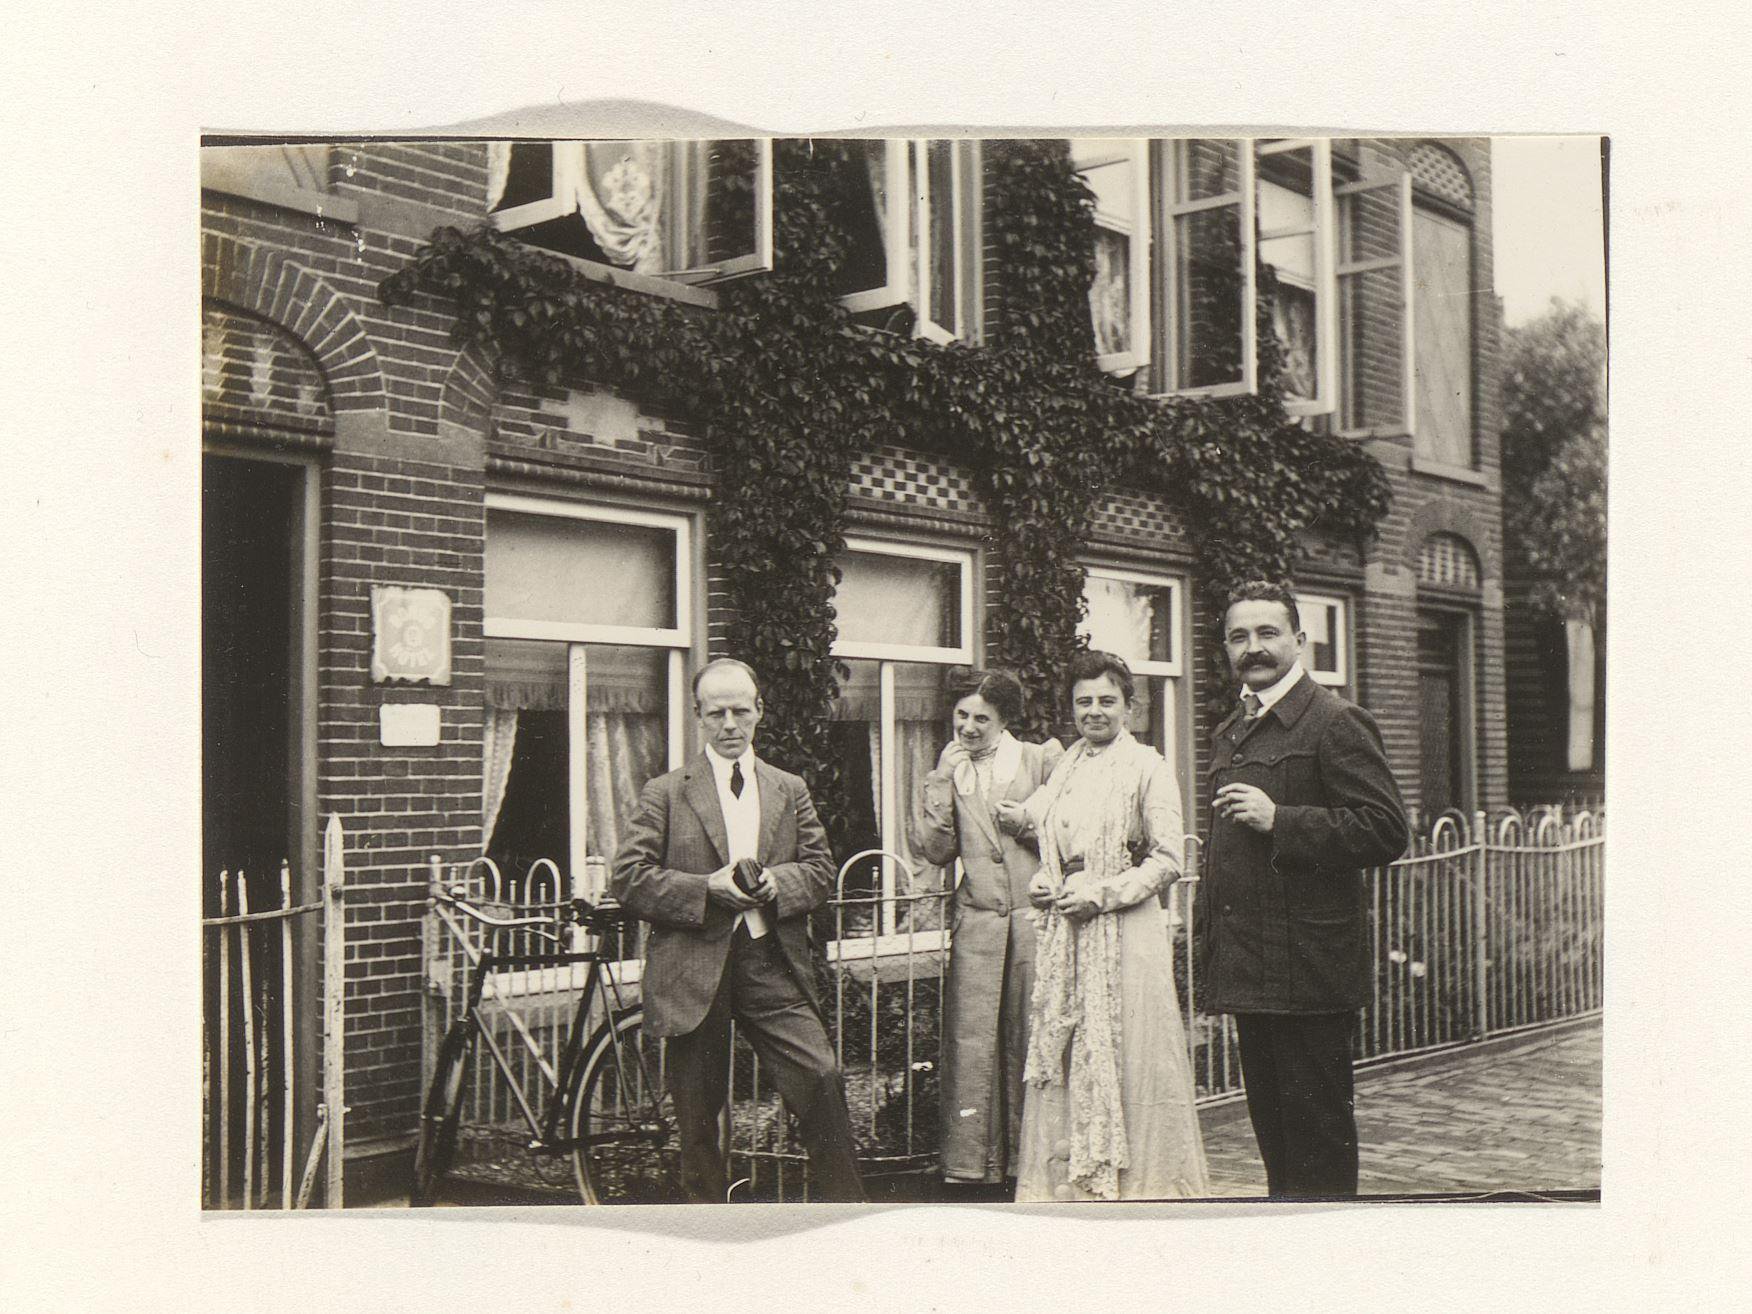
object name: photograph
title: Mannen en vrouwen bij een woning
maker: george hidderley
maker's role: fotograaf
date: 1900-1910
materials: paper, photographic support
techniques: gelatin silver print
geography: volendam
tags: adult woman, adult man, historical persons, civic architecture; edifices; dwellings